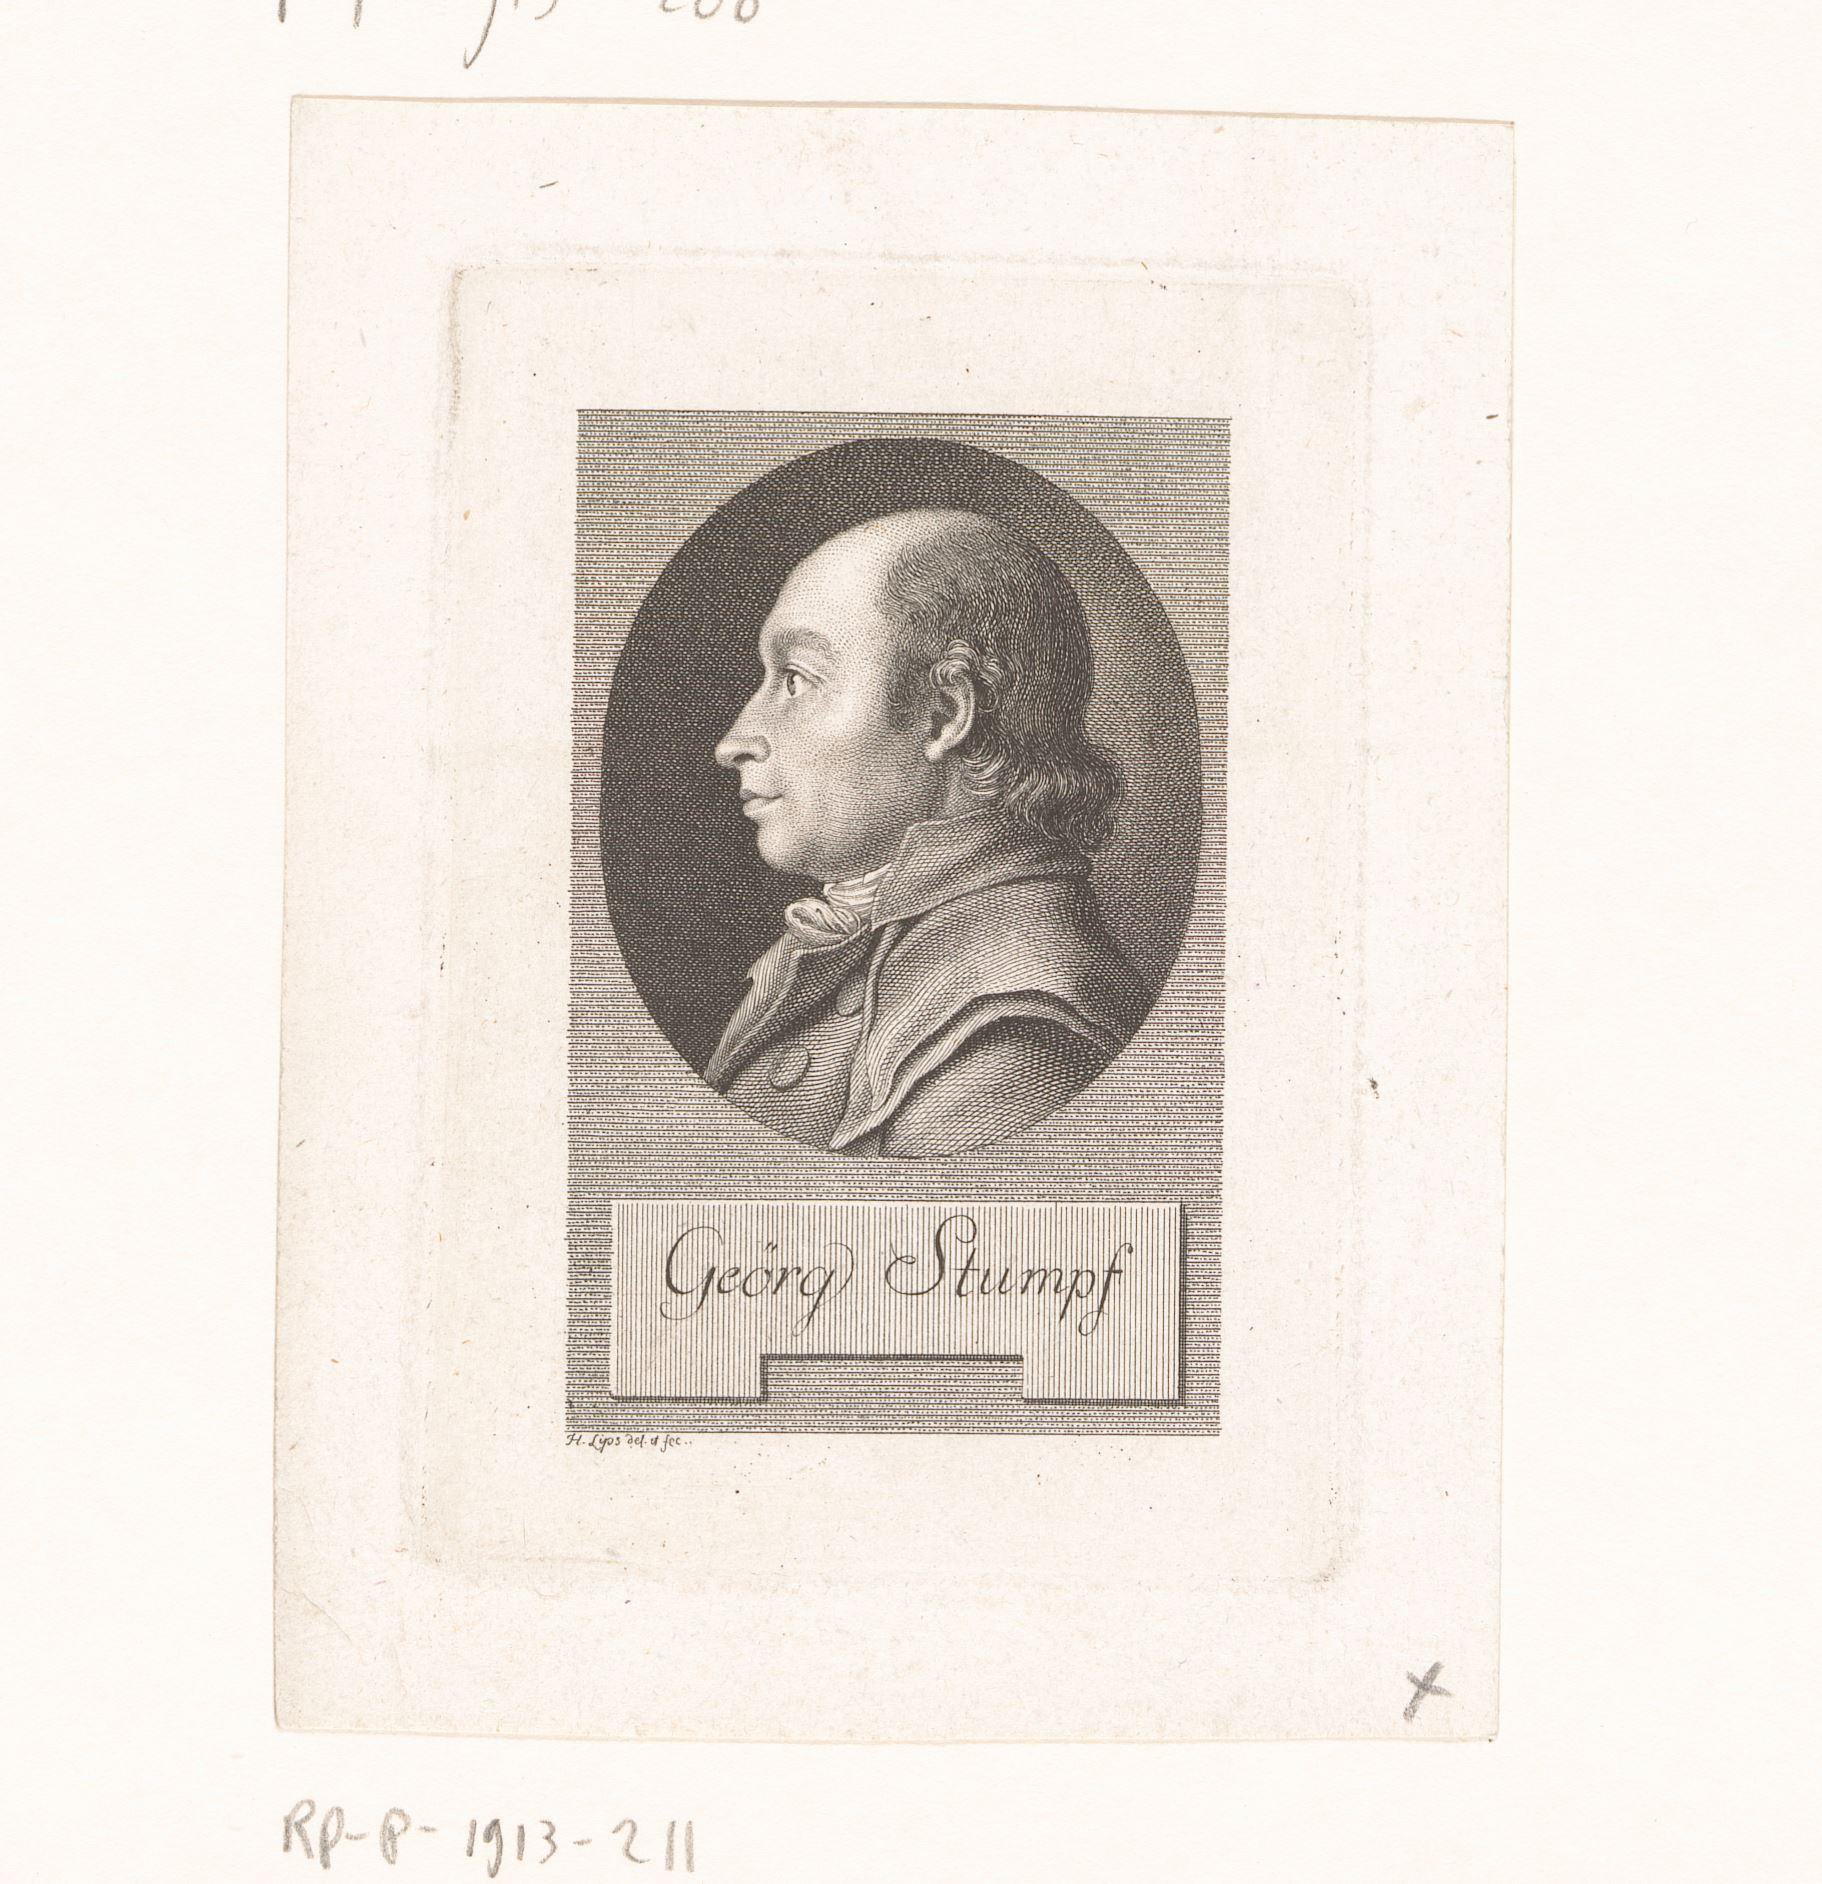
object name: print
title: Portret van Johann Georg Stumpf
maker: johann heinrich lips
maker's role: draughtsman, painter, print maker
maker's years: 1758-1817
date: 1768-1817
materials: paper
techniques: engraving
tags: theologian, historical persons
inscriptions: collector's mark: Lugt 2228